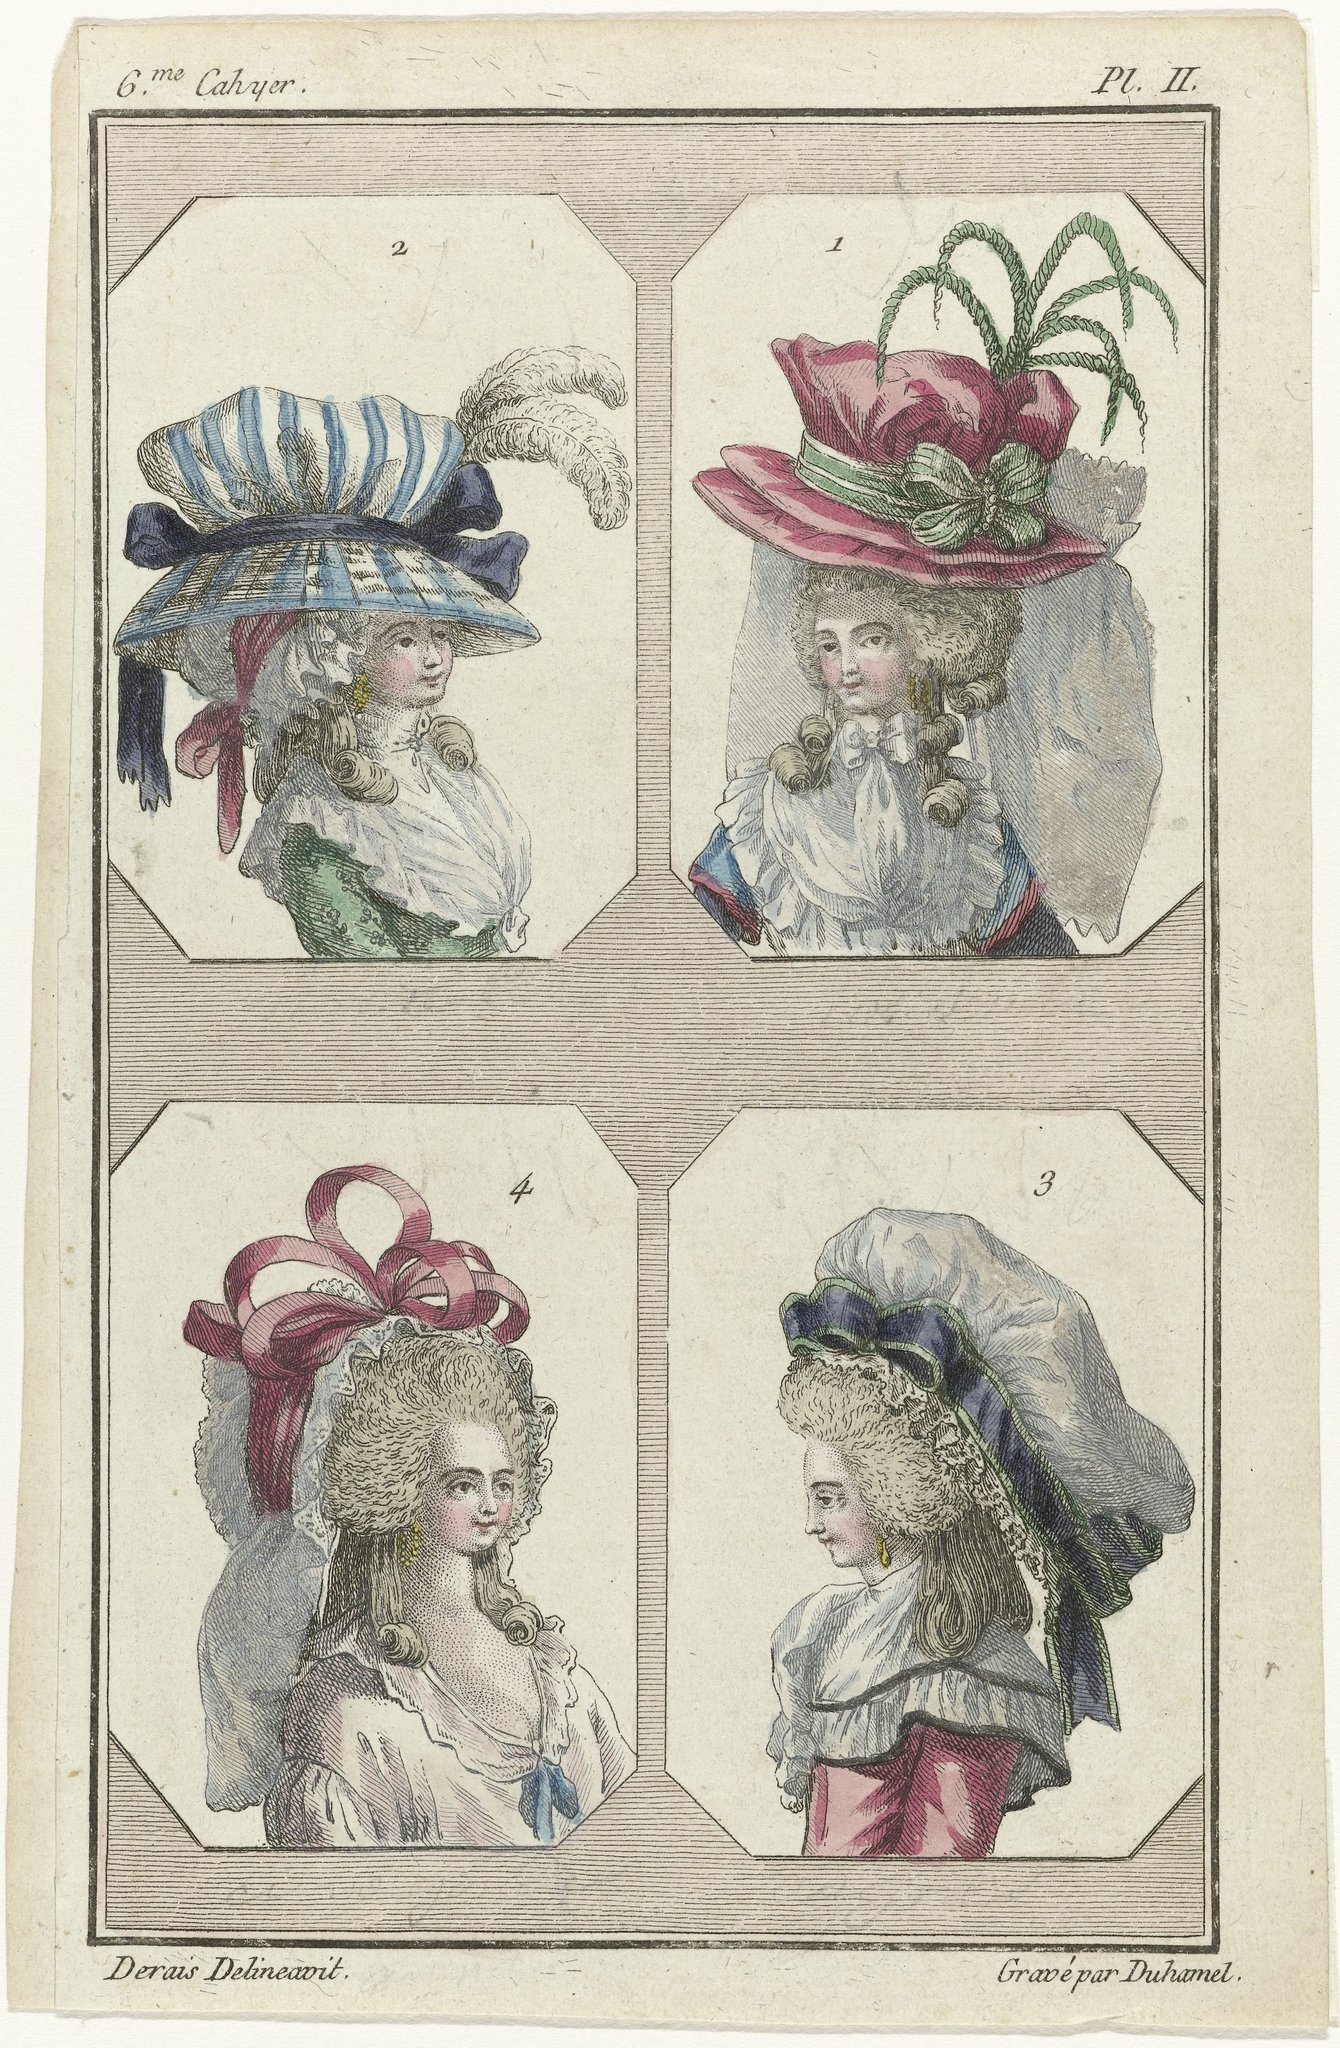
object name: fashion print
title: The First Fashion Magazine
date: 1786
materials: paper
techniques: engraving, hand coloring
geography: paris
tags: ear-rings (+ women's clothes), head-gear (capote) (+ women's clothes), border, ribbon, braid (+ women's clothes), styles of hairdress - aa - ~ women, head-gear: cap (+ women's clothes), head-gear (bonnet) (+ women's clothes), fashion plates, piece of clothing covering the breast or décolleté (fichu) (+ women's clothes)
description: The Cabinet des Modes ou les Modes Nouvelles first appeared on 15 November 1785. As the first real fashion magazine, it was published on a regular basis and wholly dedicated to news from the world of fashion. It was available by subscription only and distributed both in France and abroad. Each eight-page edition contained three hand-coloured engravings. After a year in print, the magazine changed its name to Magasin des Modes Nouvelles Françaises et Anglaises. Instead of three loose sheets, it now included a single fold-out plate depicting clothes and accessories. Publication of the Magasin ceased abruptly in 1789; after this, it was most likely succeeded by the Journal de la Mode et du Goût.